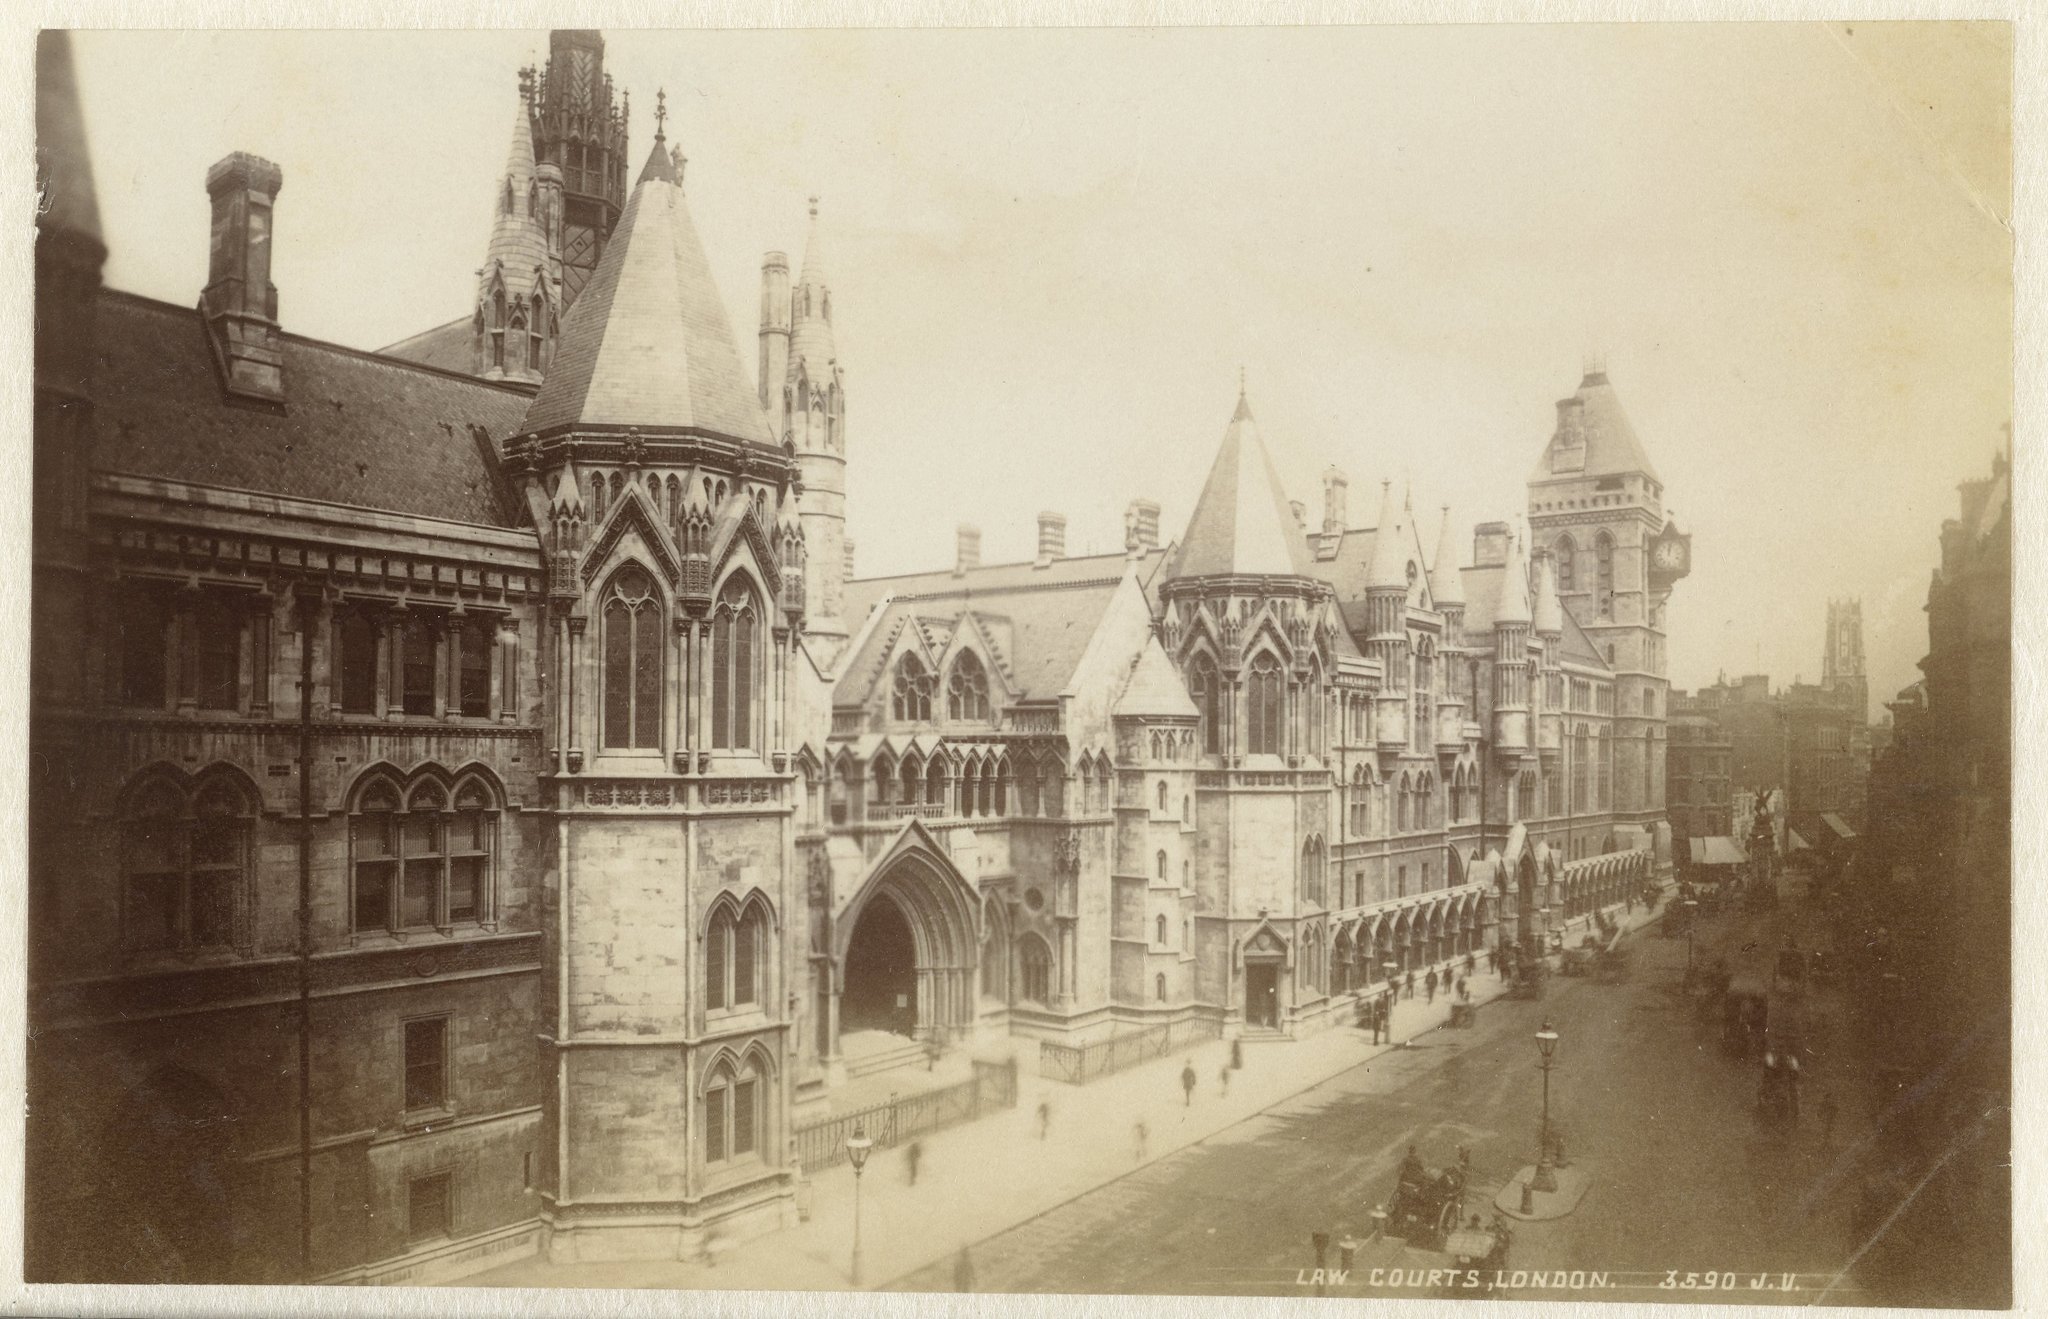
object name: photograph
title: Law Courts, Londen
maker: james valentine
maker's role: fotograaf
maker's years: 1815-1880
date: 1851-1880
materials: paper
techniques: albumen print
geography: london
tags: court building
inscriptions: number: ‘3590’